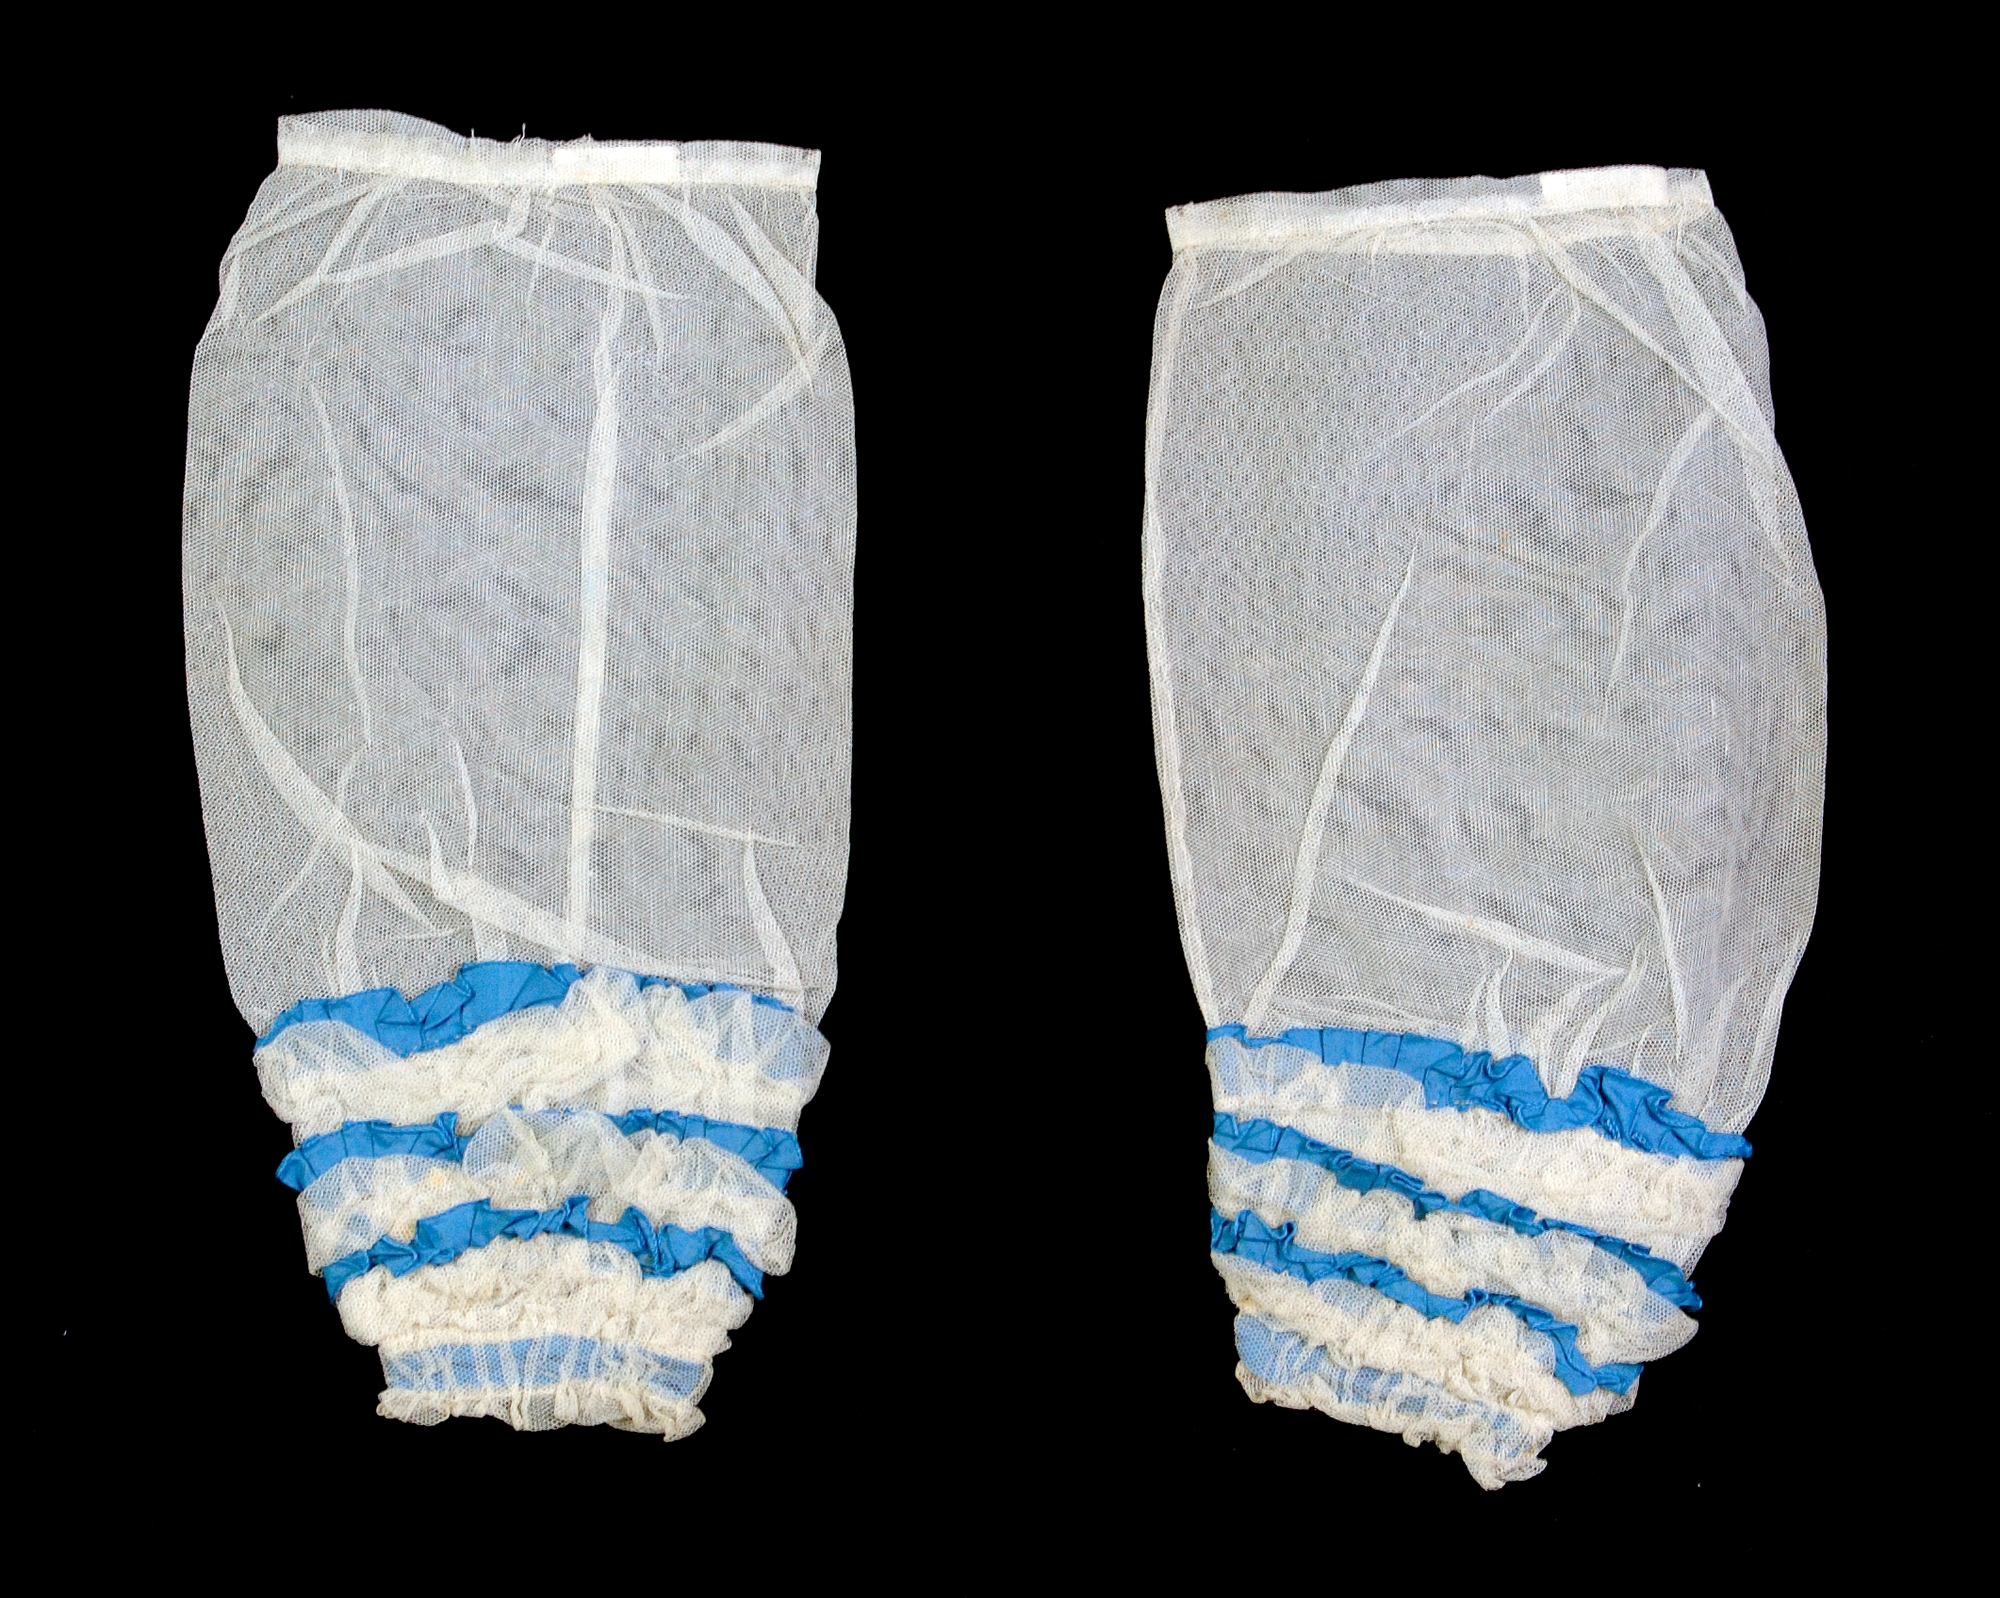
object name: undersleeves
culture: american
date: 1854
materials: silk